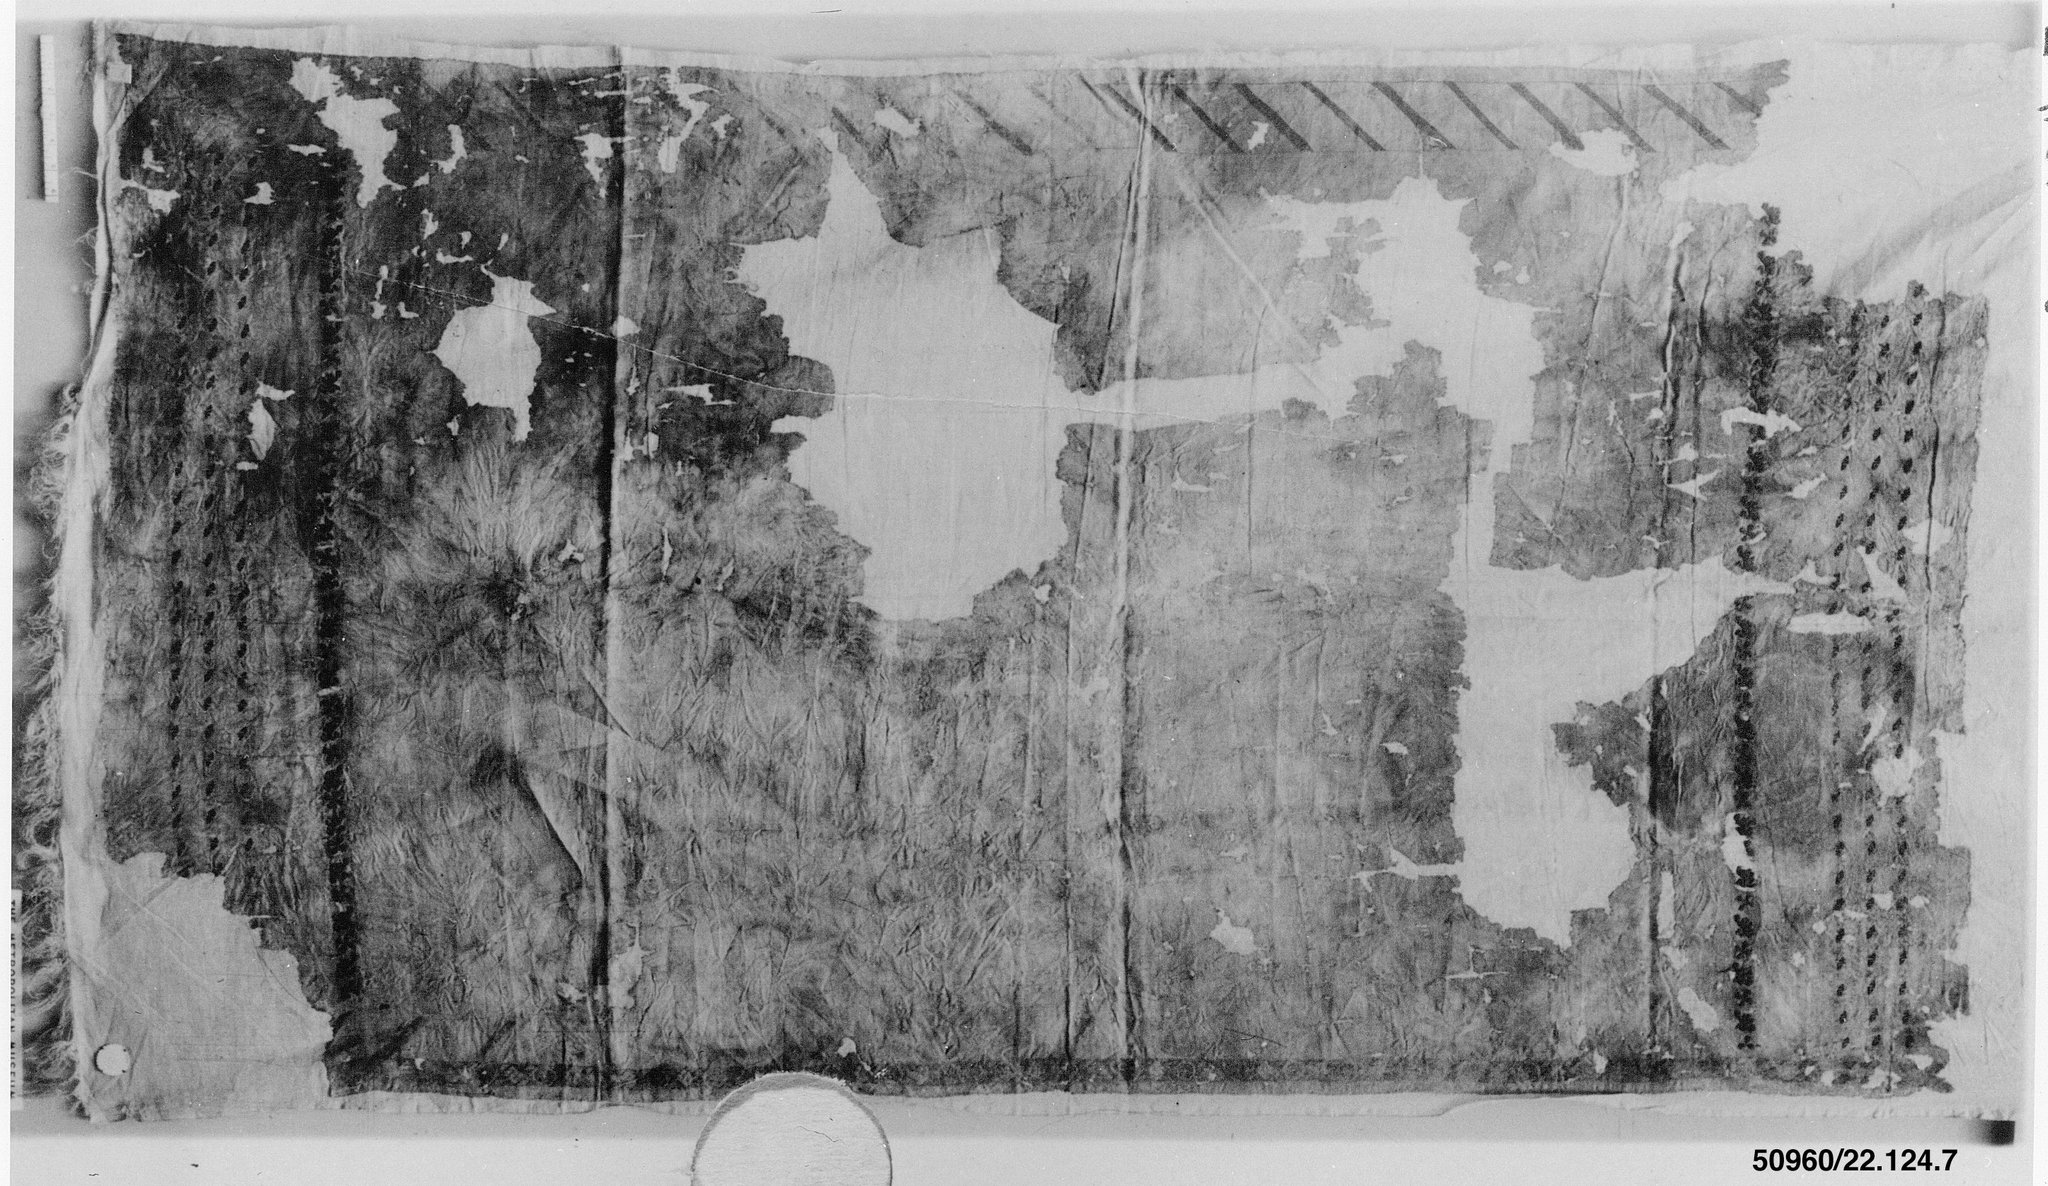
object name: cover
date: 1101-1200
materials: linen, wool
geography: egypt